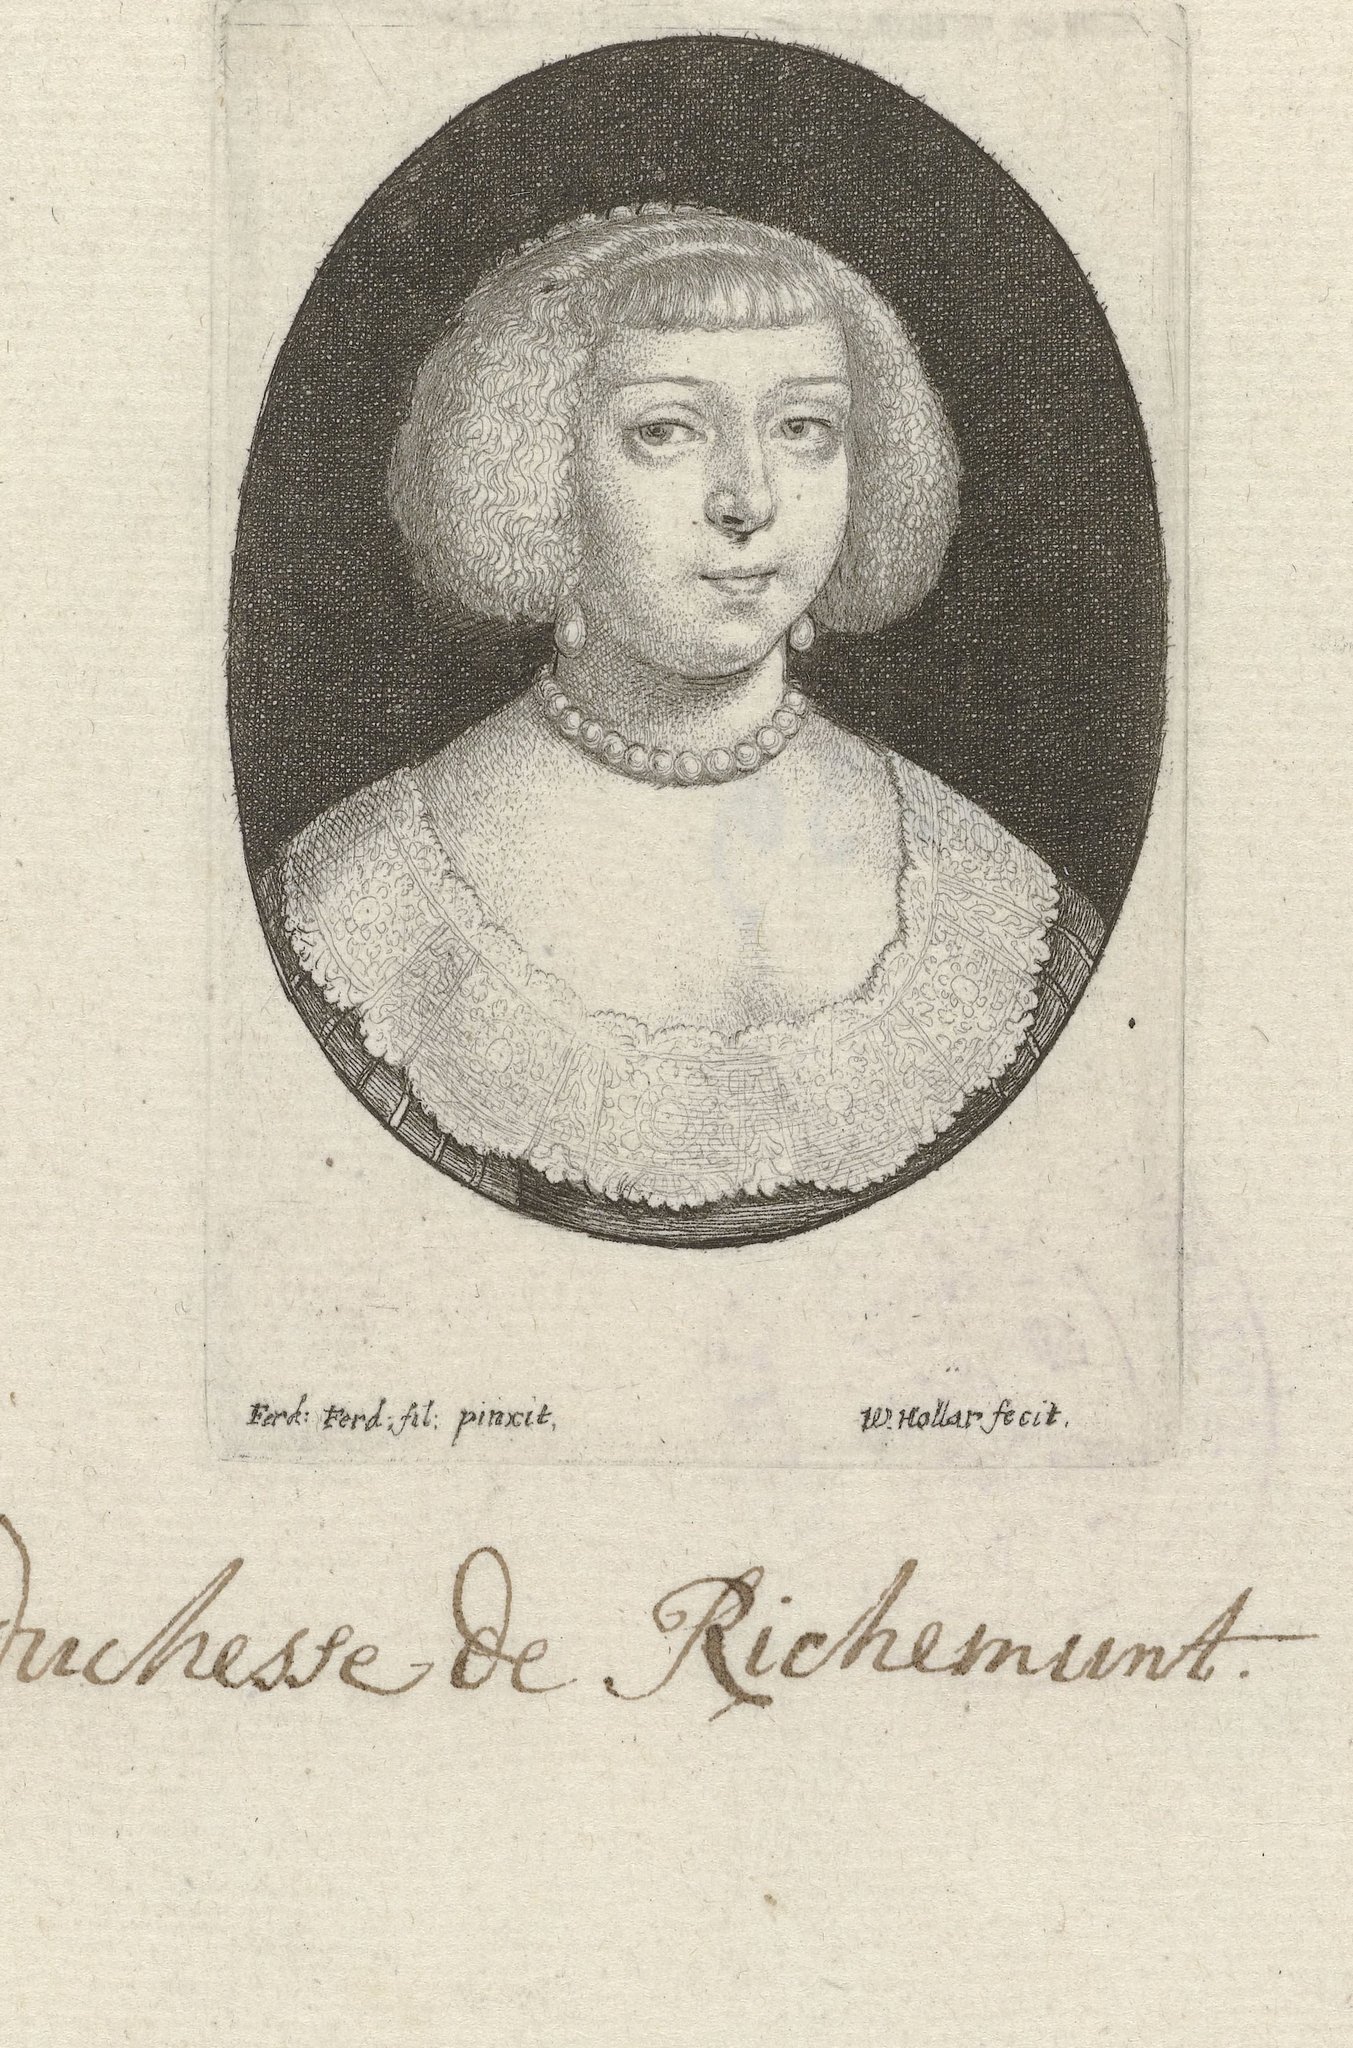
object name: print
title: Portret van een vrouw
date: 1617-1677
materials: paper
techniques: etching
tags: historical persons not known by name - bb - woman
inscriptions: collector's mark: Lugt 240, inscription